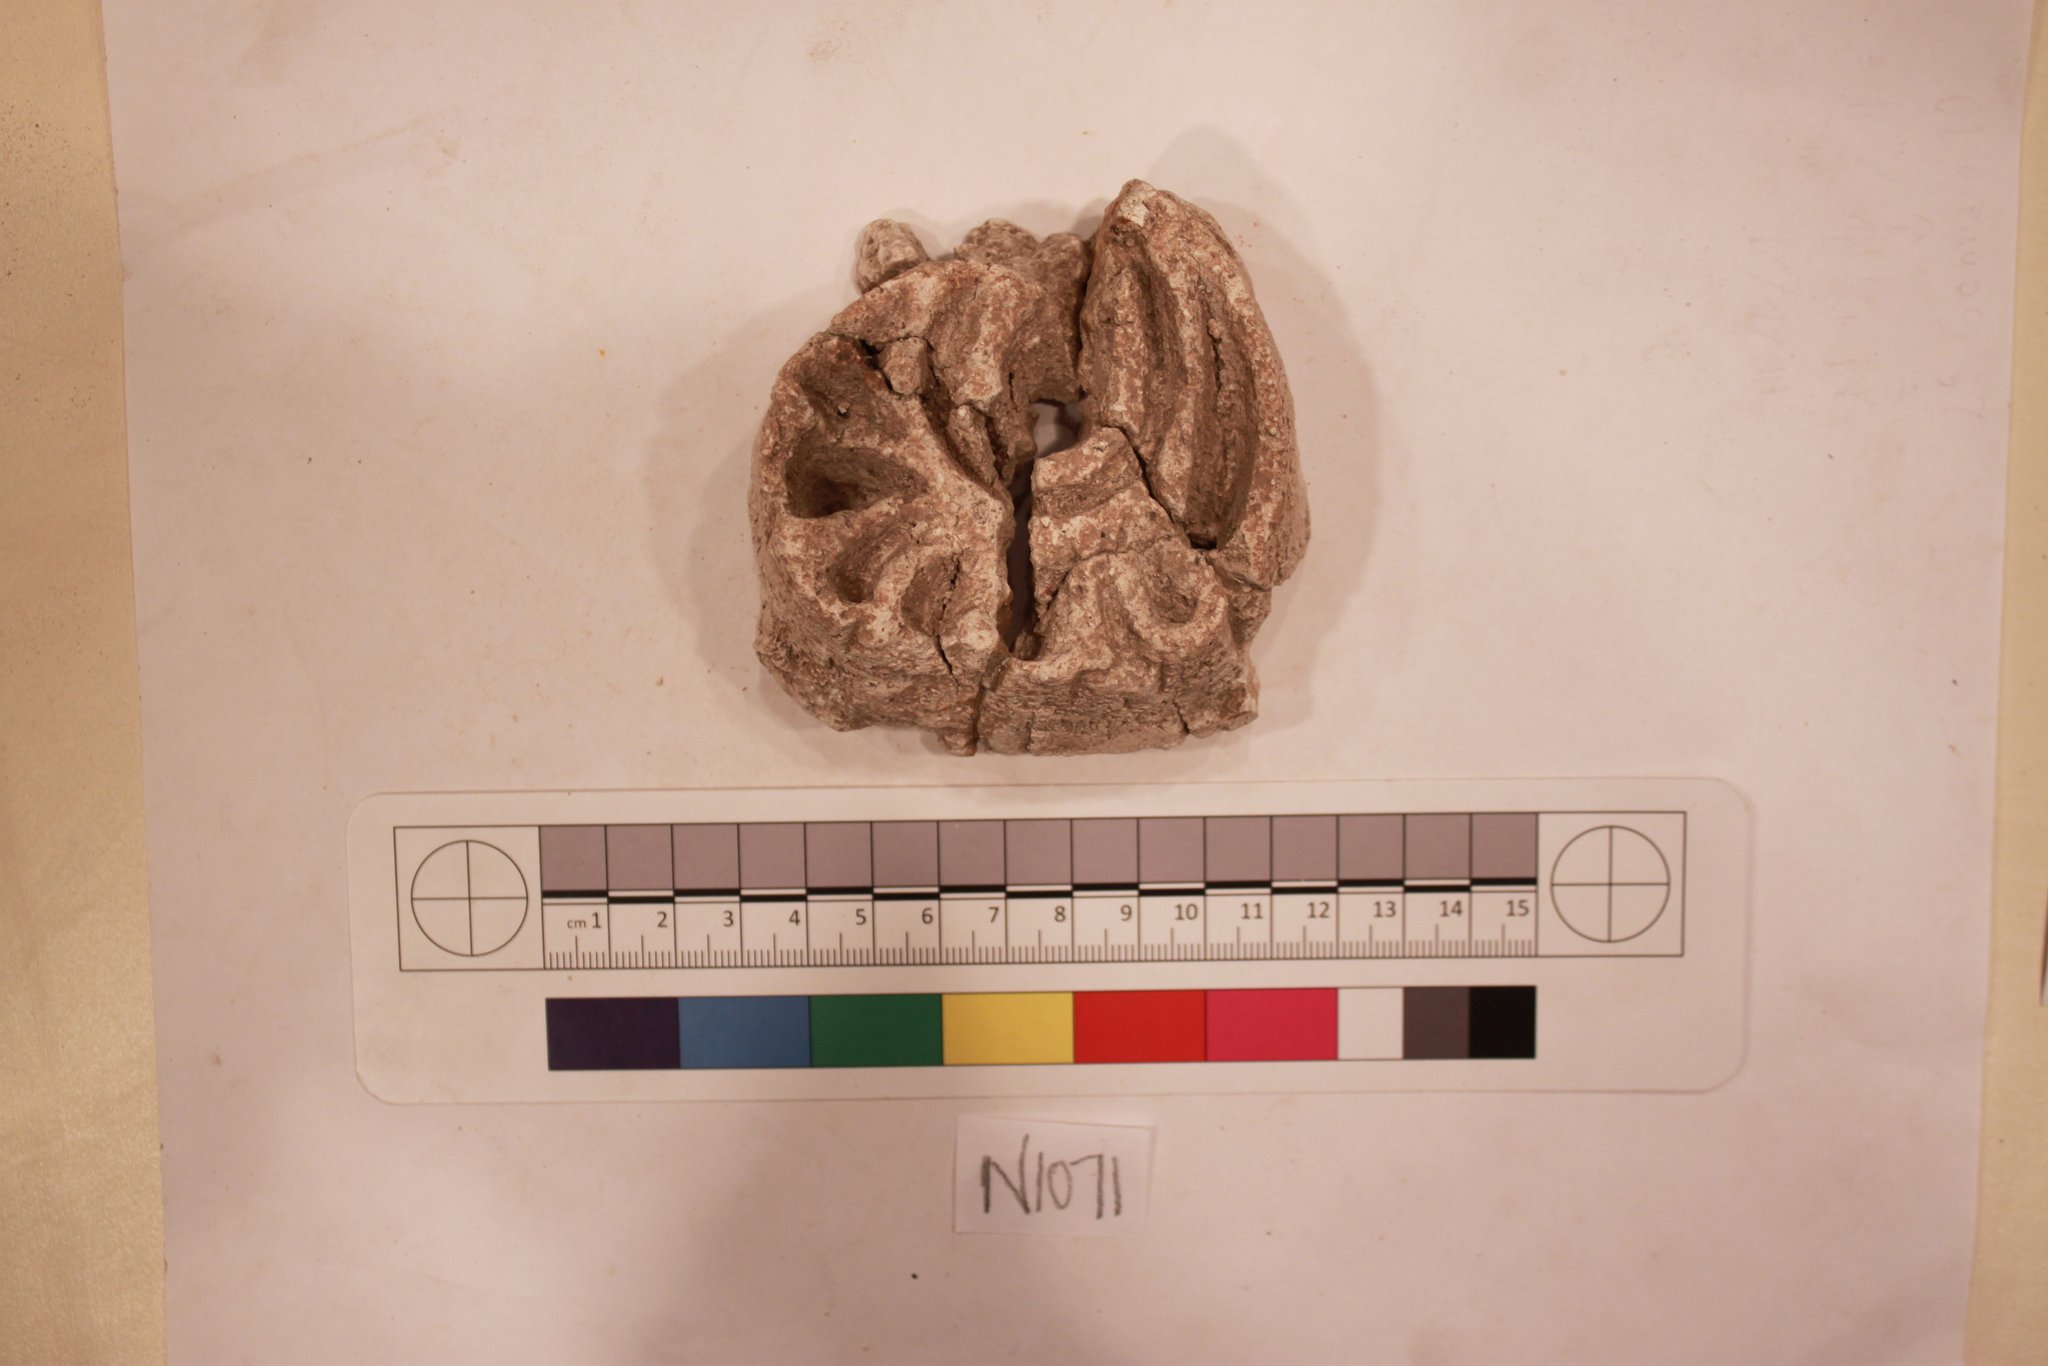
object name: fragment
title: Stucco Fragment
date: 701-1200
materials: plaster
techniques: carving, painting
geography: iran